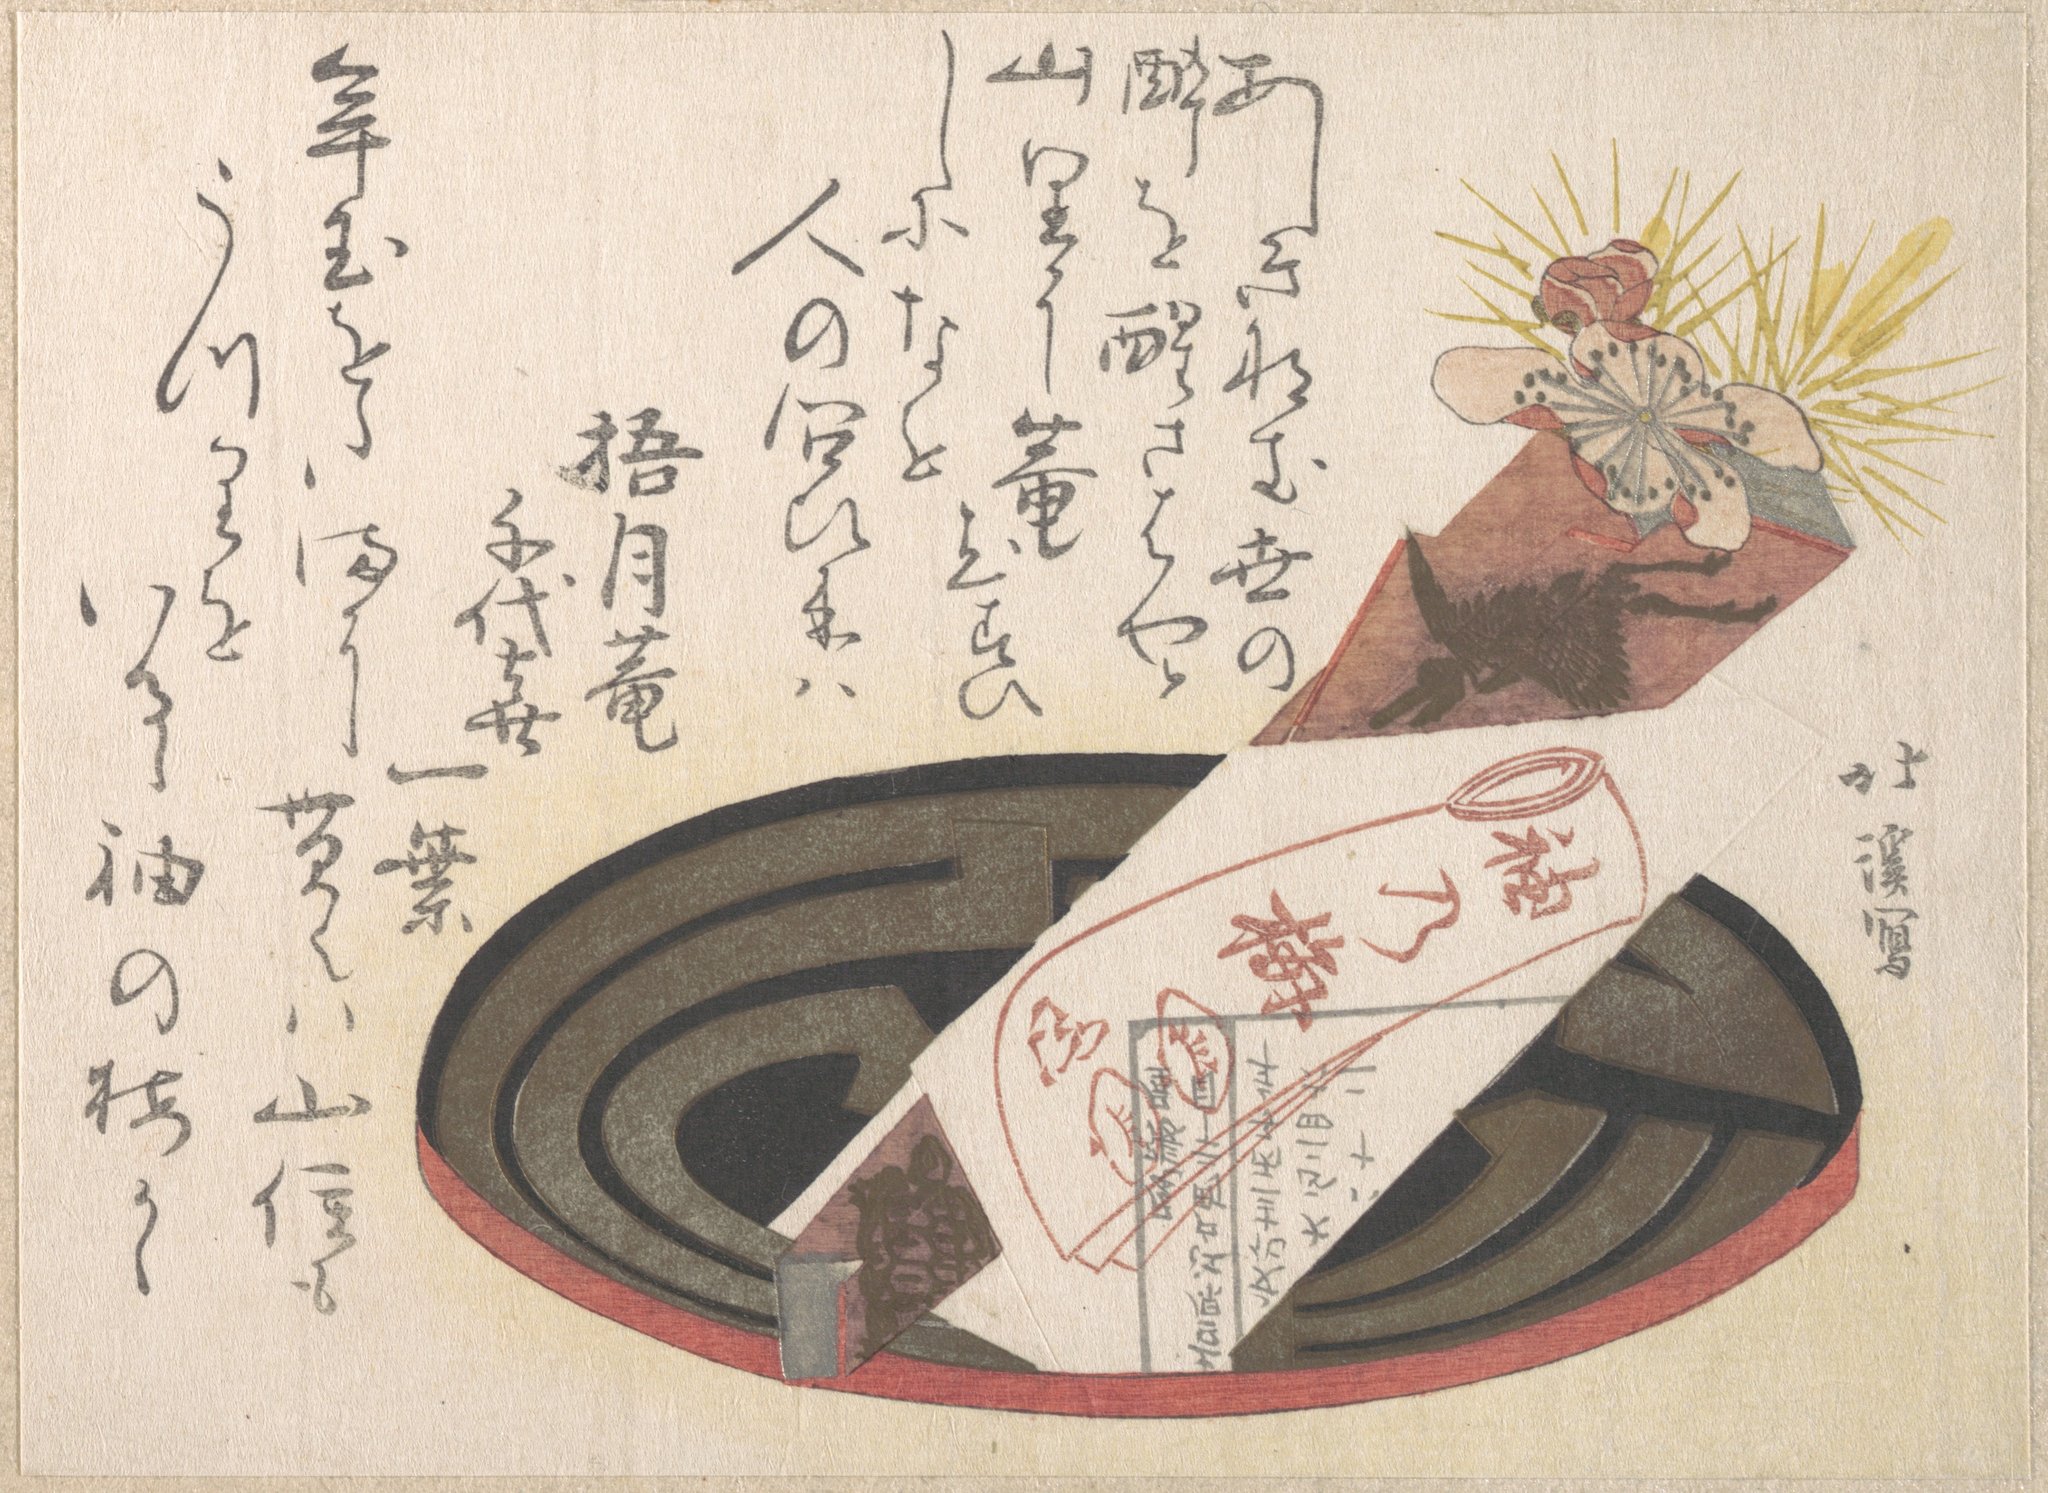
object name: print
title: Tray with Noshi Paper (Noshi Indicates a Present)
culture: japanese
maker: totoya hokkei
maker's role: artist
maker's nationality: japanese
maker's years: 1780-1850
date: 1816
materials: ink, paper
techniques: surimono, woodblock print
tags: flowers,trays